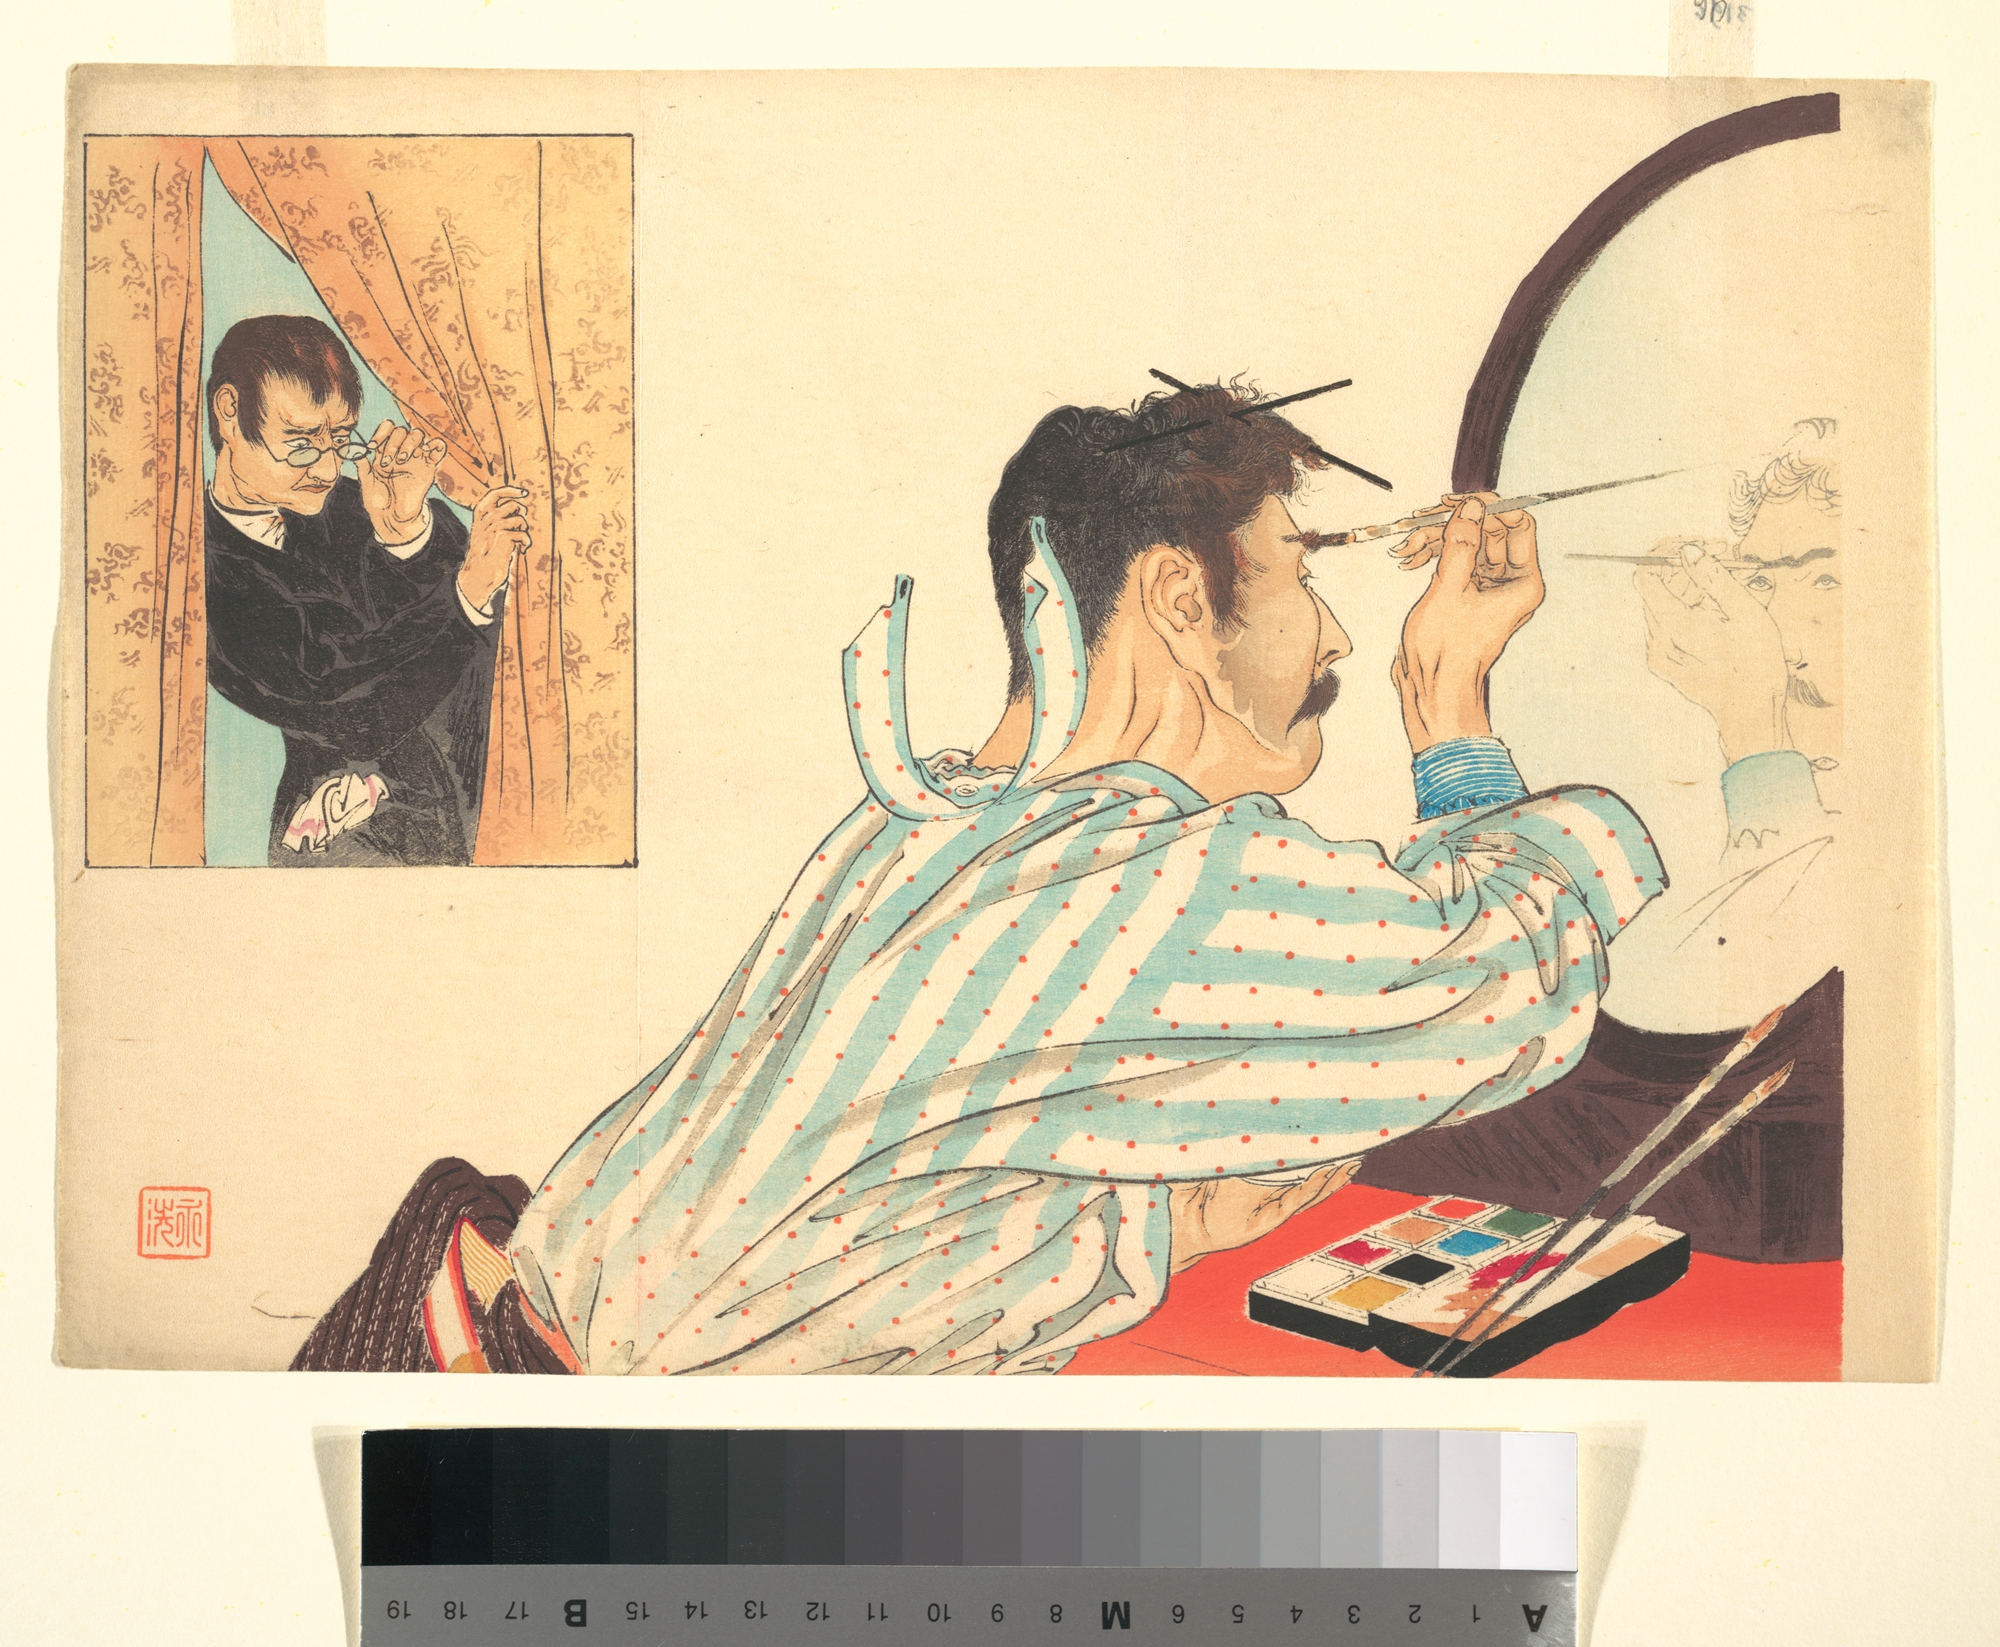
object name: print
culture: japanese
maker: tomioka eisen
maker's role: artist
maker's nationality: japanese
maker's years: 1864-1905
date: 1906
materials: ink, paper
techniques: woodblock print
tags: men